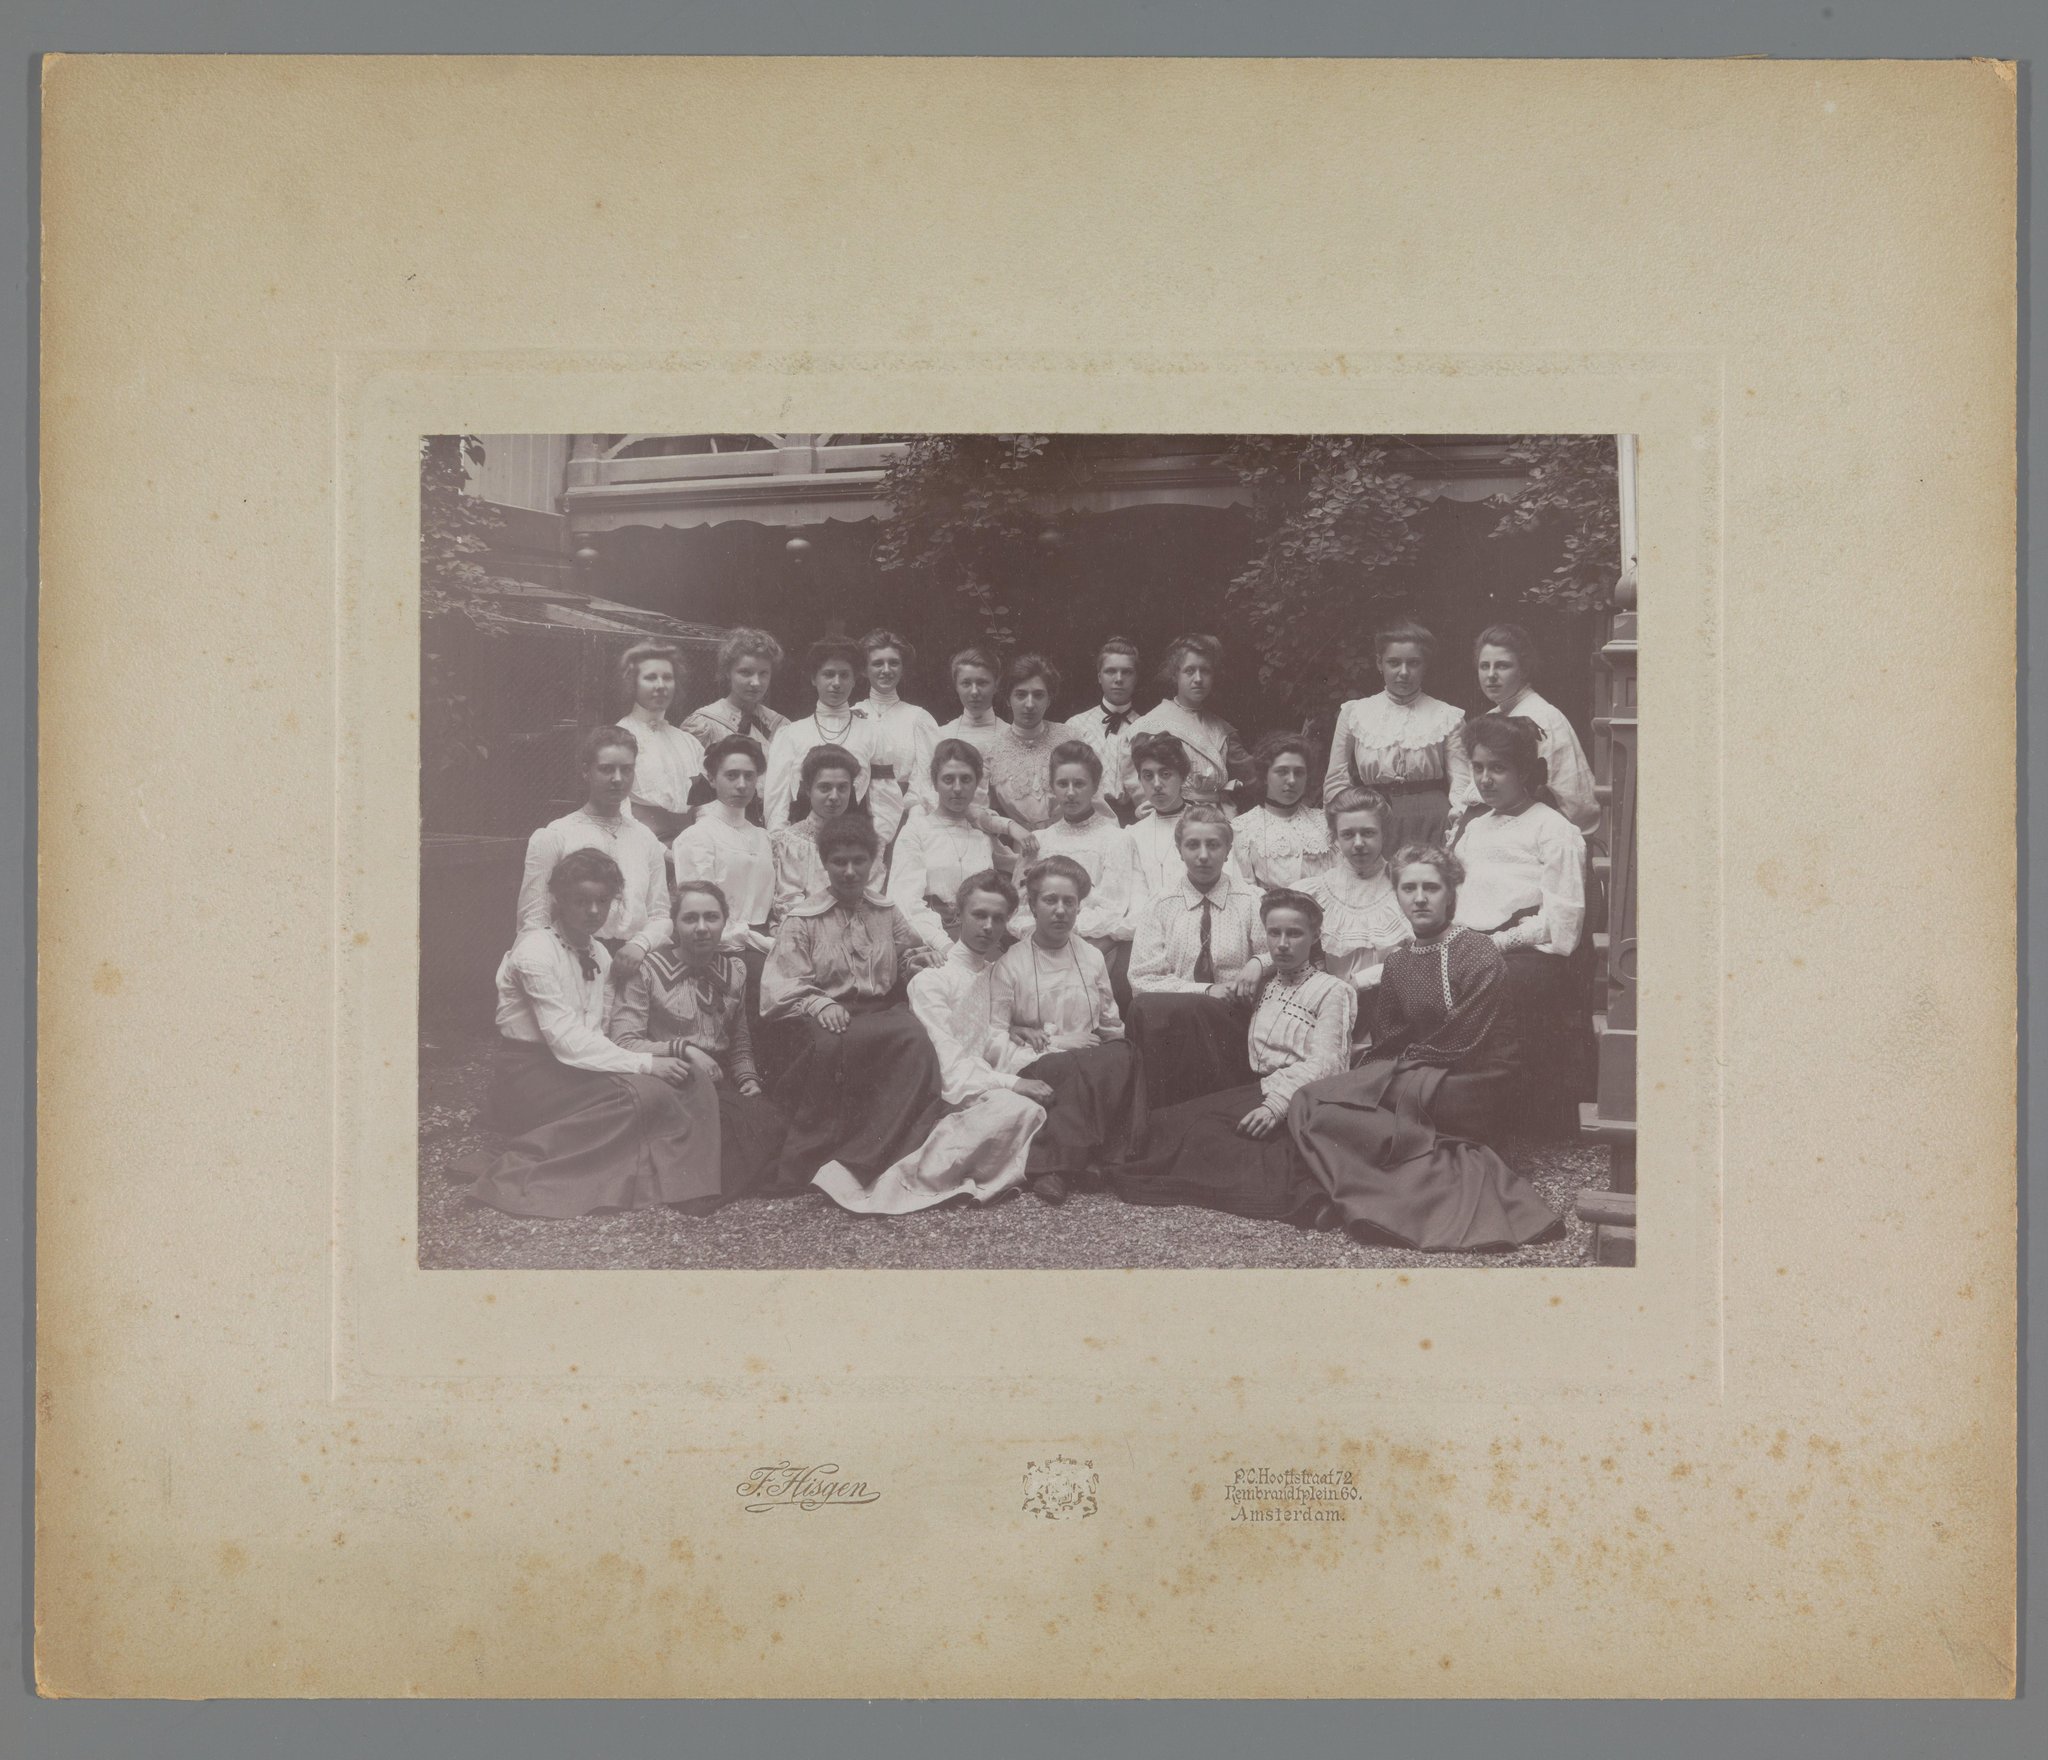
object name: photograph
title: (...) V B H.B.S. voor meisjes Juli 1905, Keizersgracht Amsterdam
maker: friedrich carel hisgen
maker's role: fotograaf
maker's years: 1846-1912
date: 1905-1907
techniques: collodion silver print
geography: amsterdam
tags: anonymous historical persons portrayed in a group, in a group-portrait, amsterdam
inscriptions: signature: ‘F. Hisgen, p.c. Hooftstraat 72, Rembrandtplein 60 Amsterdam’, annotation: ‘Achterste rij van links naar rechts: Ans Zwaardemaker, Harre Valeton, Flora Ralker, Cor v.d. Brul, Jo Schonemeyer, Lies Lioni, Tuda Snethlage, Greet Sibbelee, Gerda Coops, Annemie Reisenbach. Middenste rij van links naar rechts: Be Houwing, louise Schaap, Saar Franken, Suze Simons, Grudavan Overzee, Antoinette Vogin, Lous Kok, Lilie Weill. Onderste rij van links naar rechts: Adele Frantsen, Lize Elias, Elly Chotzen, Geertje de Lint, Bettie Avas, Aumie Tieman, Lena Bok, Mien Ruhl, Jansje WAttjes. V B H.B.S. voor Meisjes 1905 Keizersgracht Amsterdam’